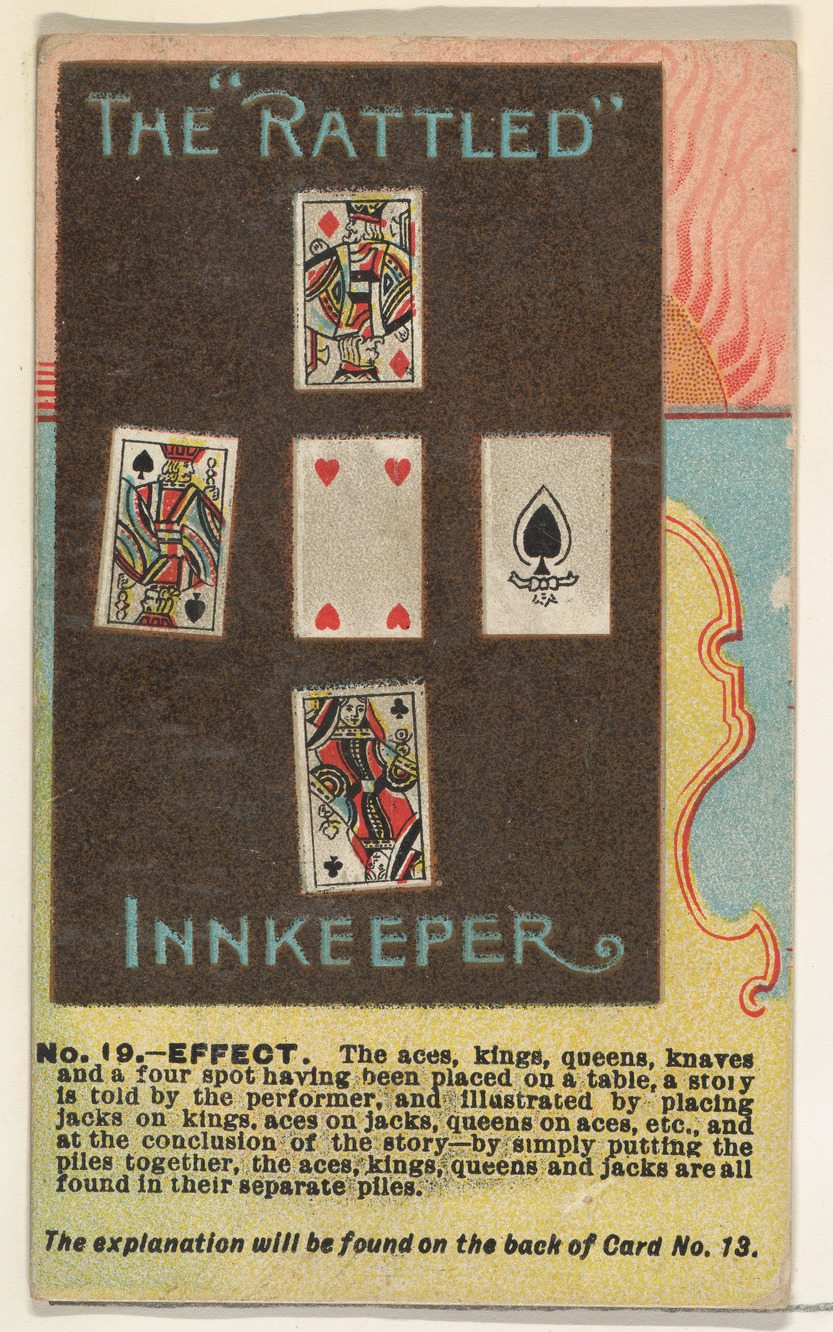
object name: print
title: Number 19, The Rattled Innkeeper, from the Tricks with Cards series (N138) issued by W. Duke, Sons & Co. to promote Honest Long Cut Tobacco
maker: w. duke, sons & co.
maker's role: publisher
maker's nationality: american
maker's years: 1870-1920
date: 1887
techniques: color lithograph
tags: magic,playing cards